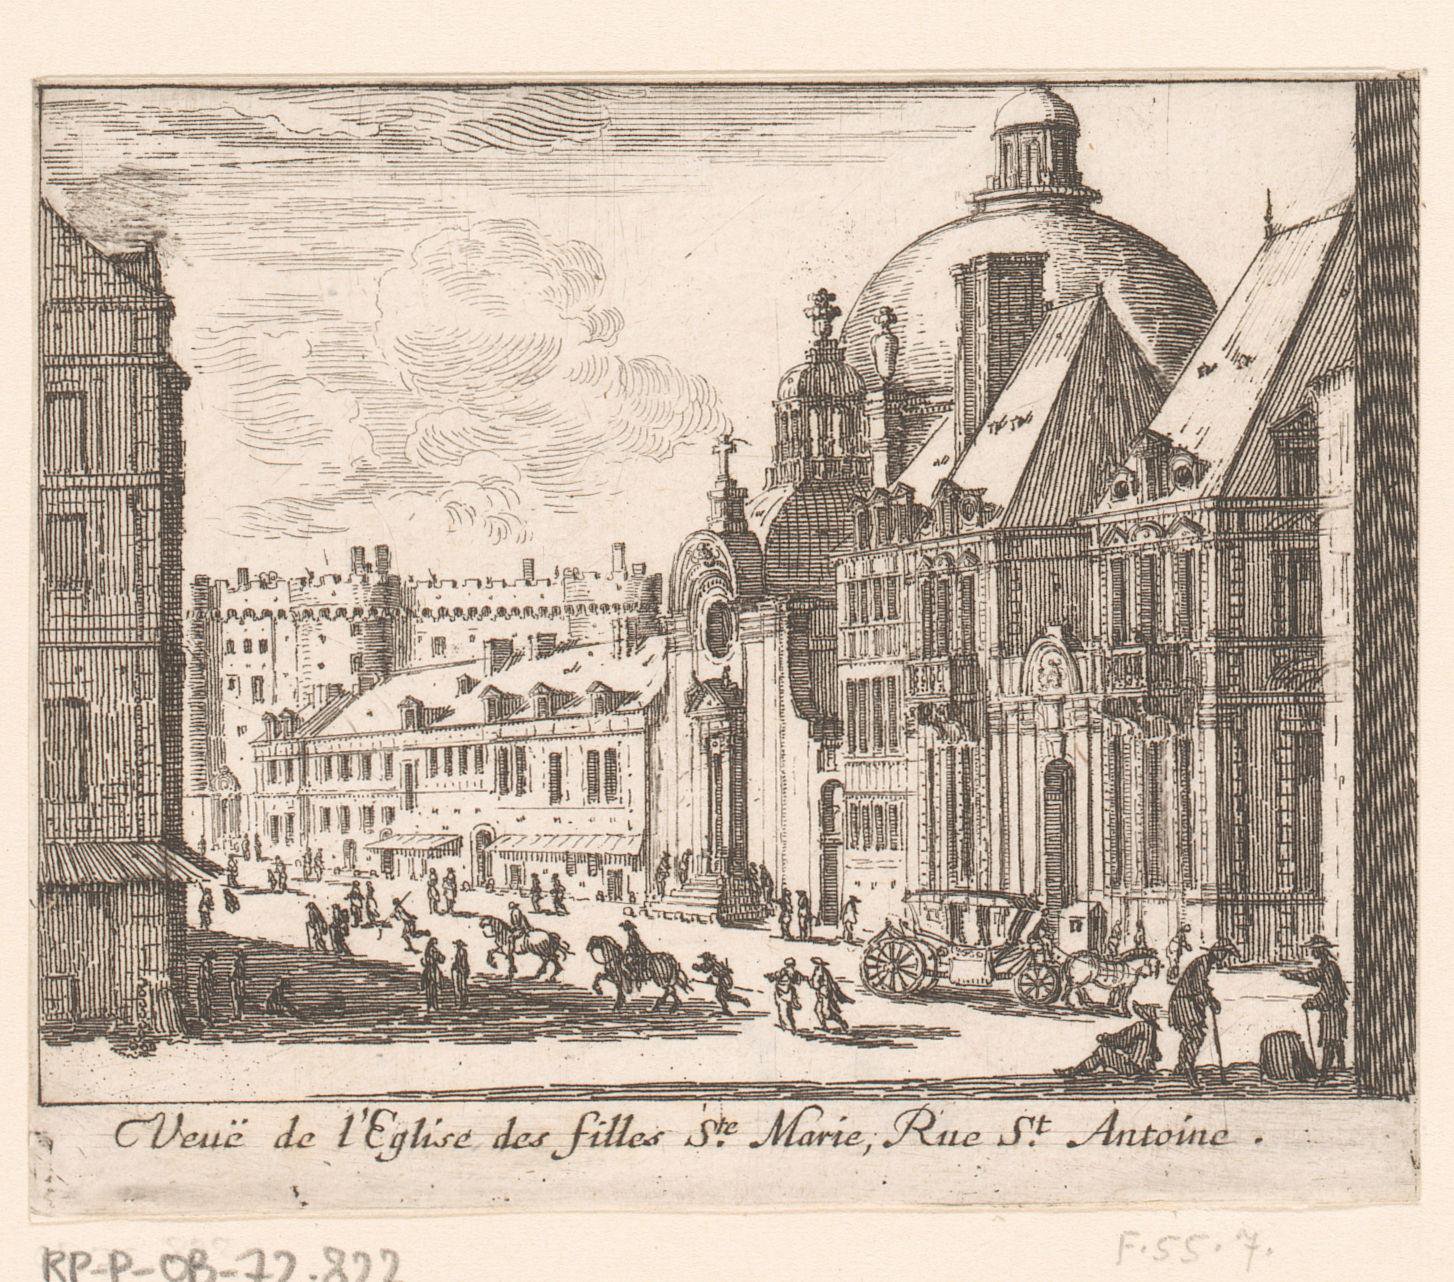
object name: print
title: Vues de Paris et de France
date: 1631-1661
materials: paper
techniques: etching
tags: church (exterior), landscape with tower or castle (+ city(-scape) with figures, staffage)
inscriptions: collector's mark: Lugt 240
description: Prent maakt deel uit van een ongenummerde serie van zestien prenten.